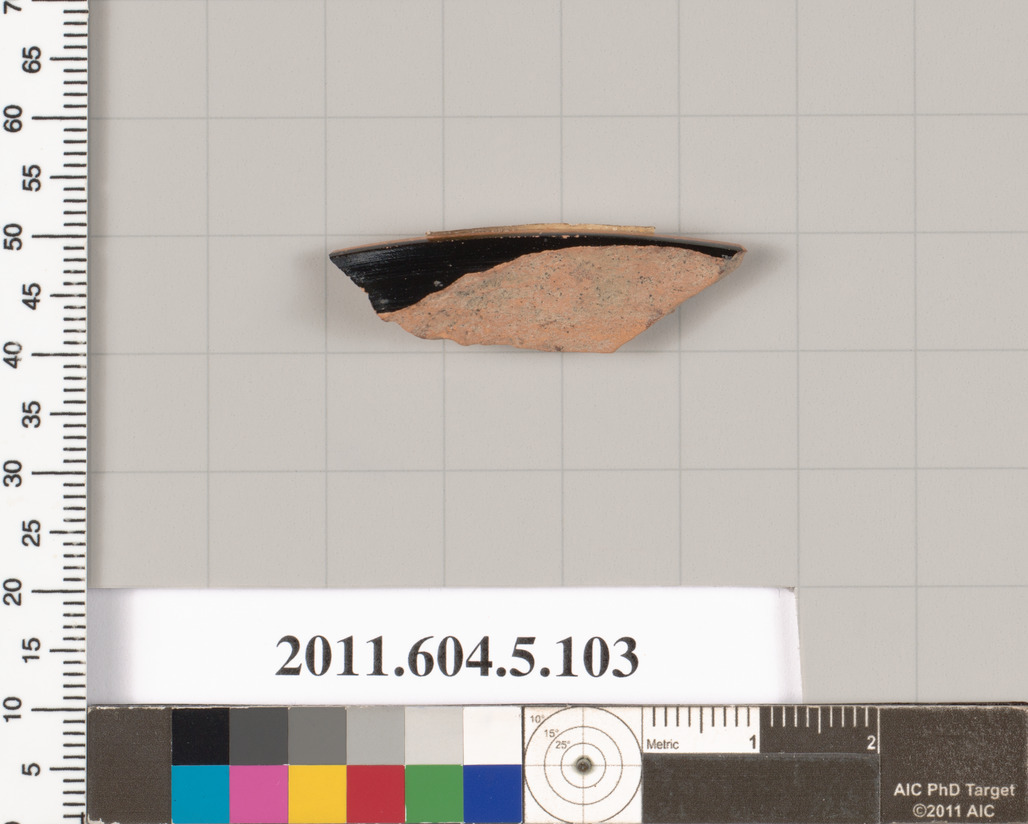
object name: kylix fragment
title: Terracotta fragment of a stemless kylix (drinking cup)?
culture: greek, attic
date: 470-450 BCE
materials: terracotta